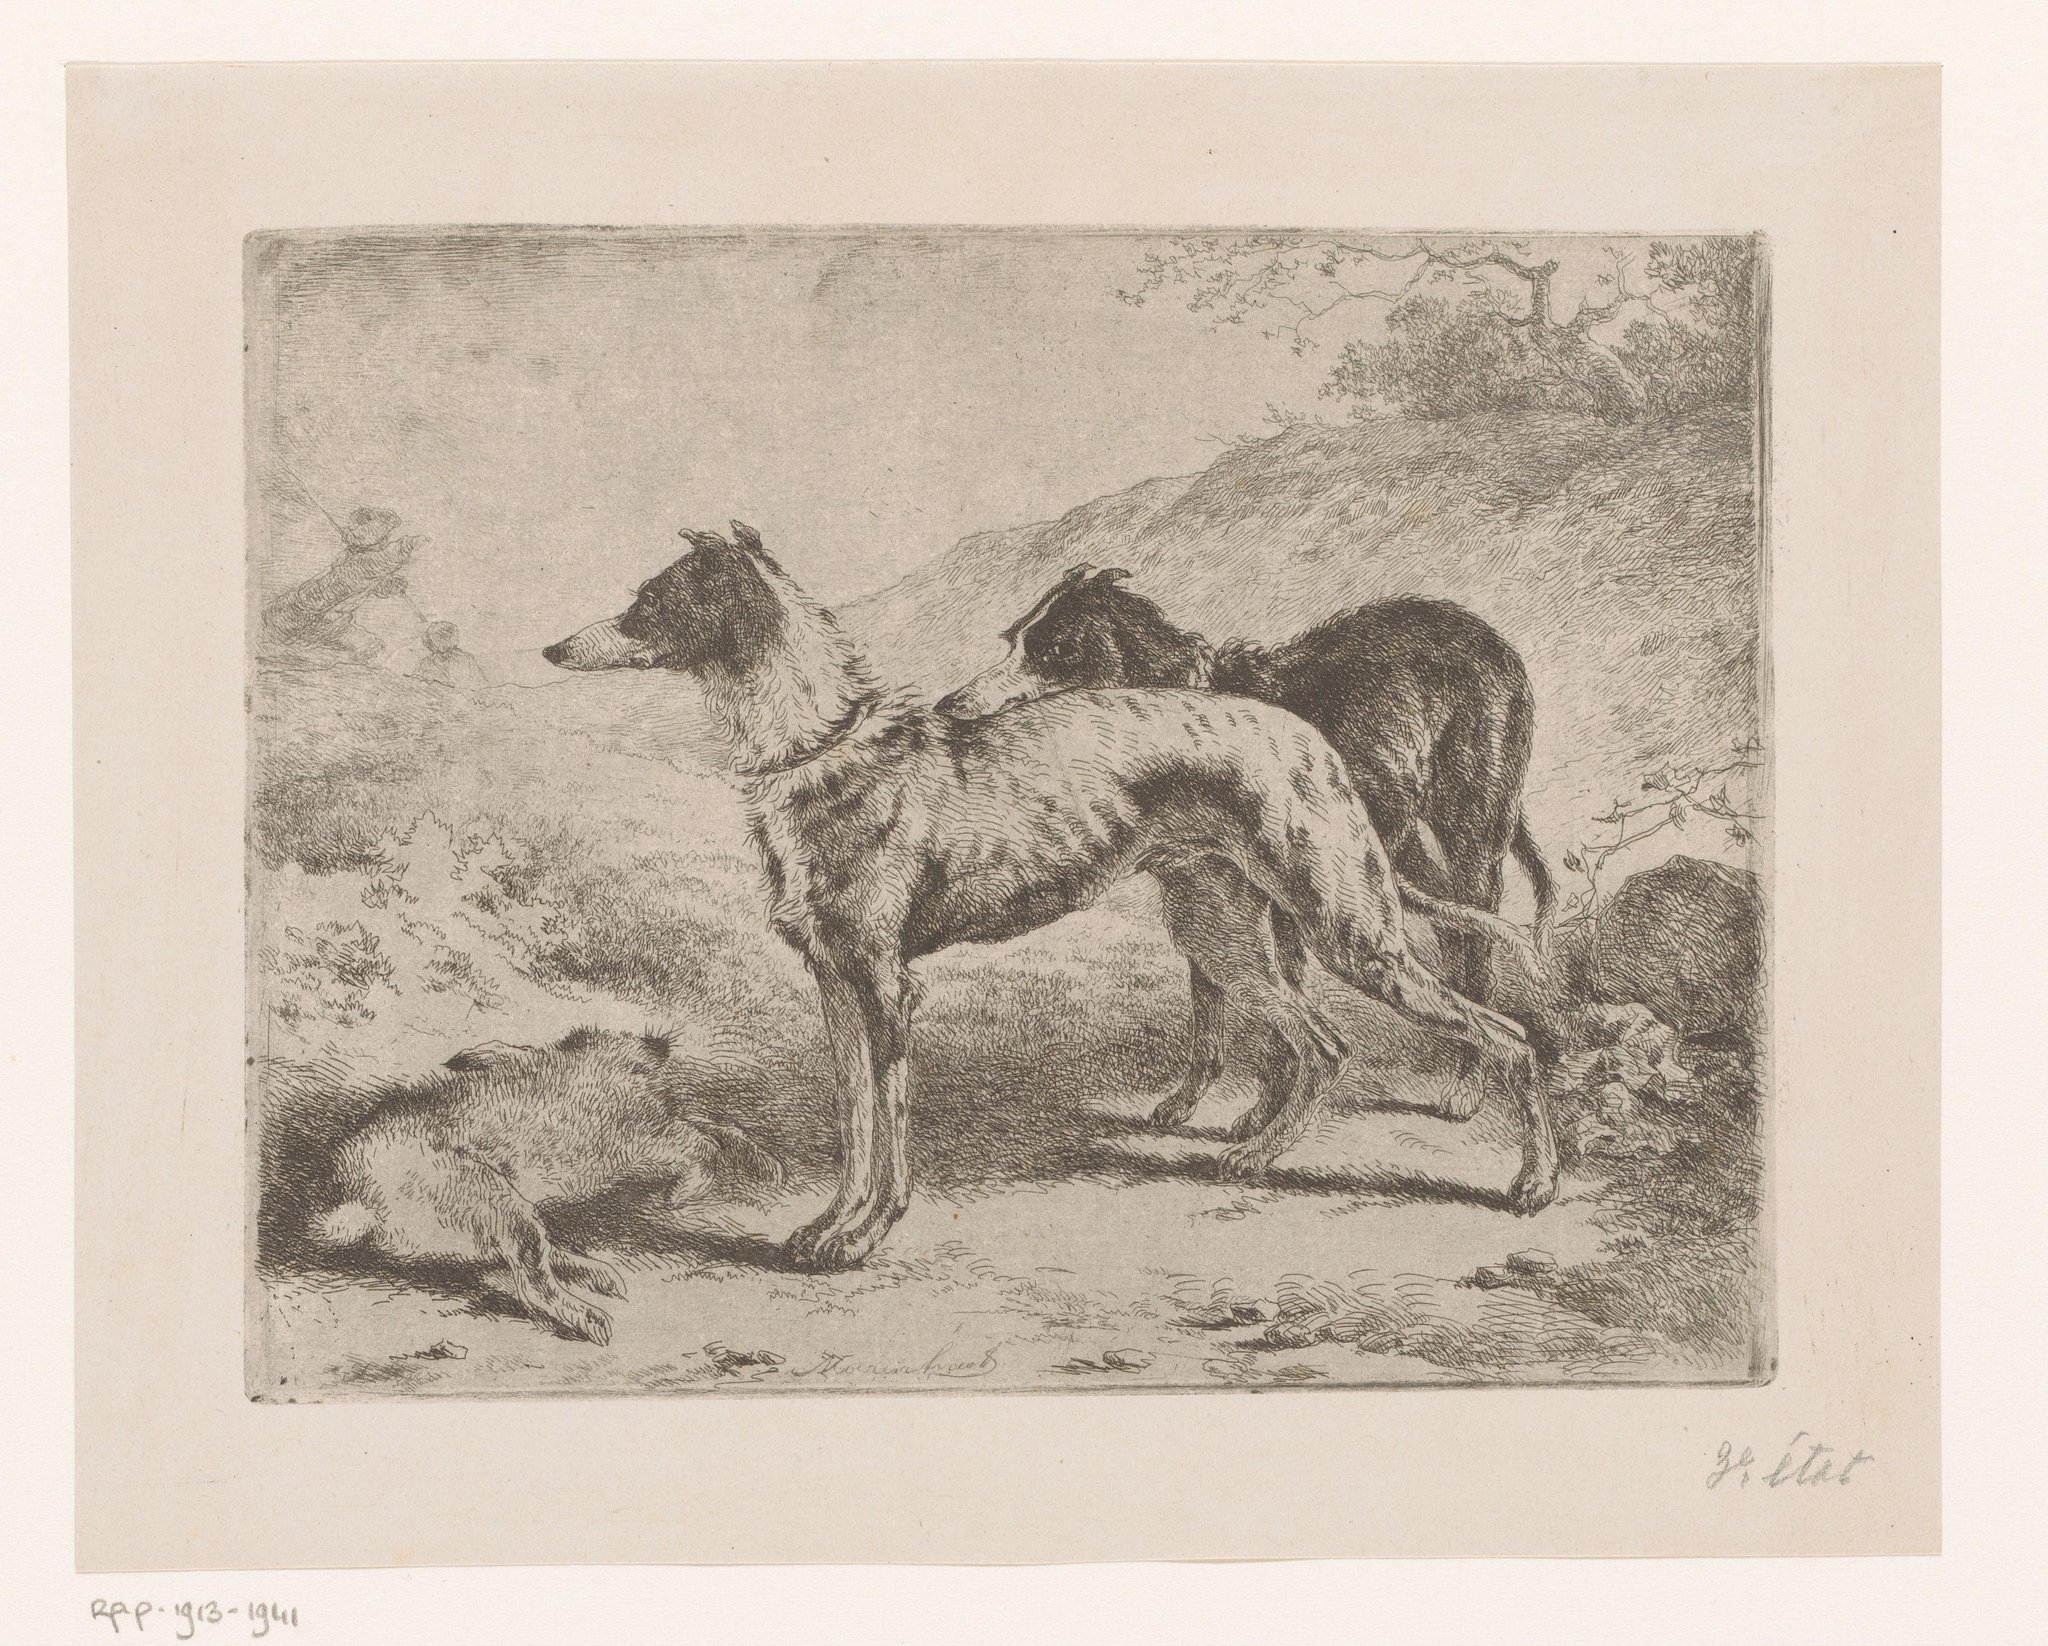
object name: print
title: Twee hazewindhonden bij een dode haas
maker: joseph moerenhout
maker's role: draughtsman, painter, print maker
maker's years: 1801-1874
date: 1811-1874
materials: paper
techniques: etching, intaglio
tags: hunting dogs, rodents: hare, hare-hunting, rabbit-hunting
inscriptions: collector's mark: Lugt 1485, collector's mark: Lugt 2228